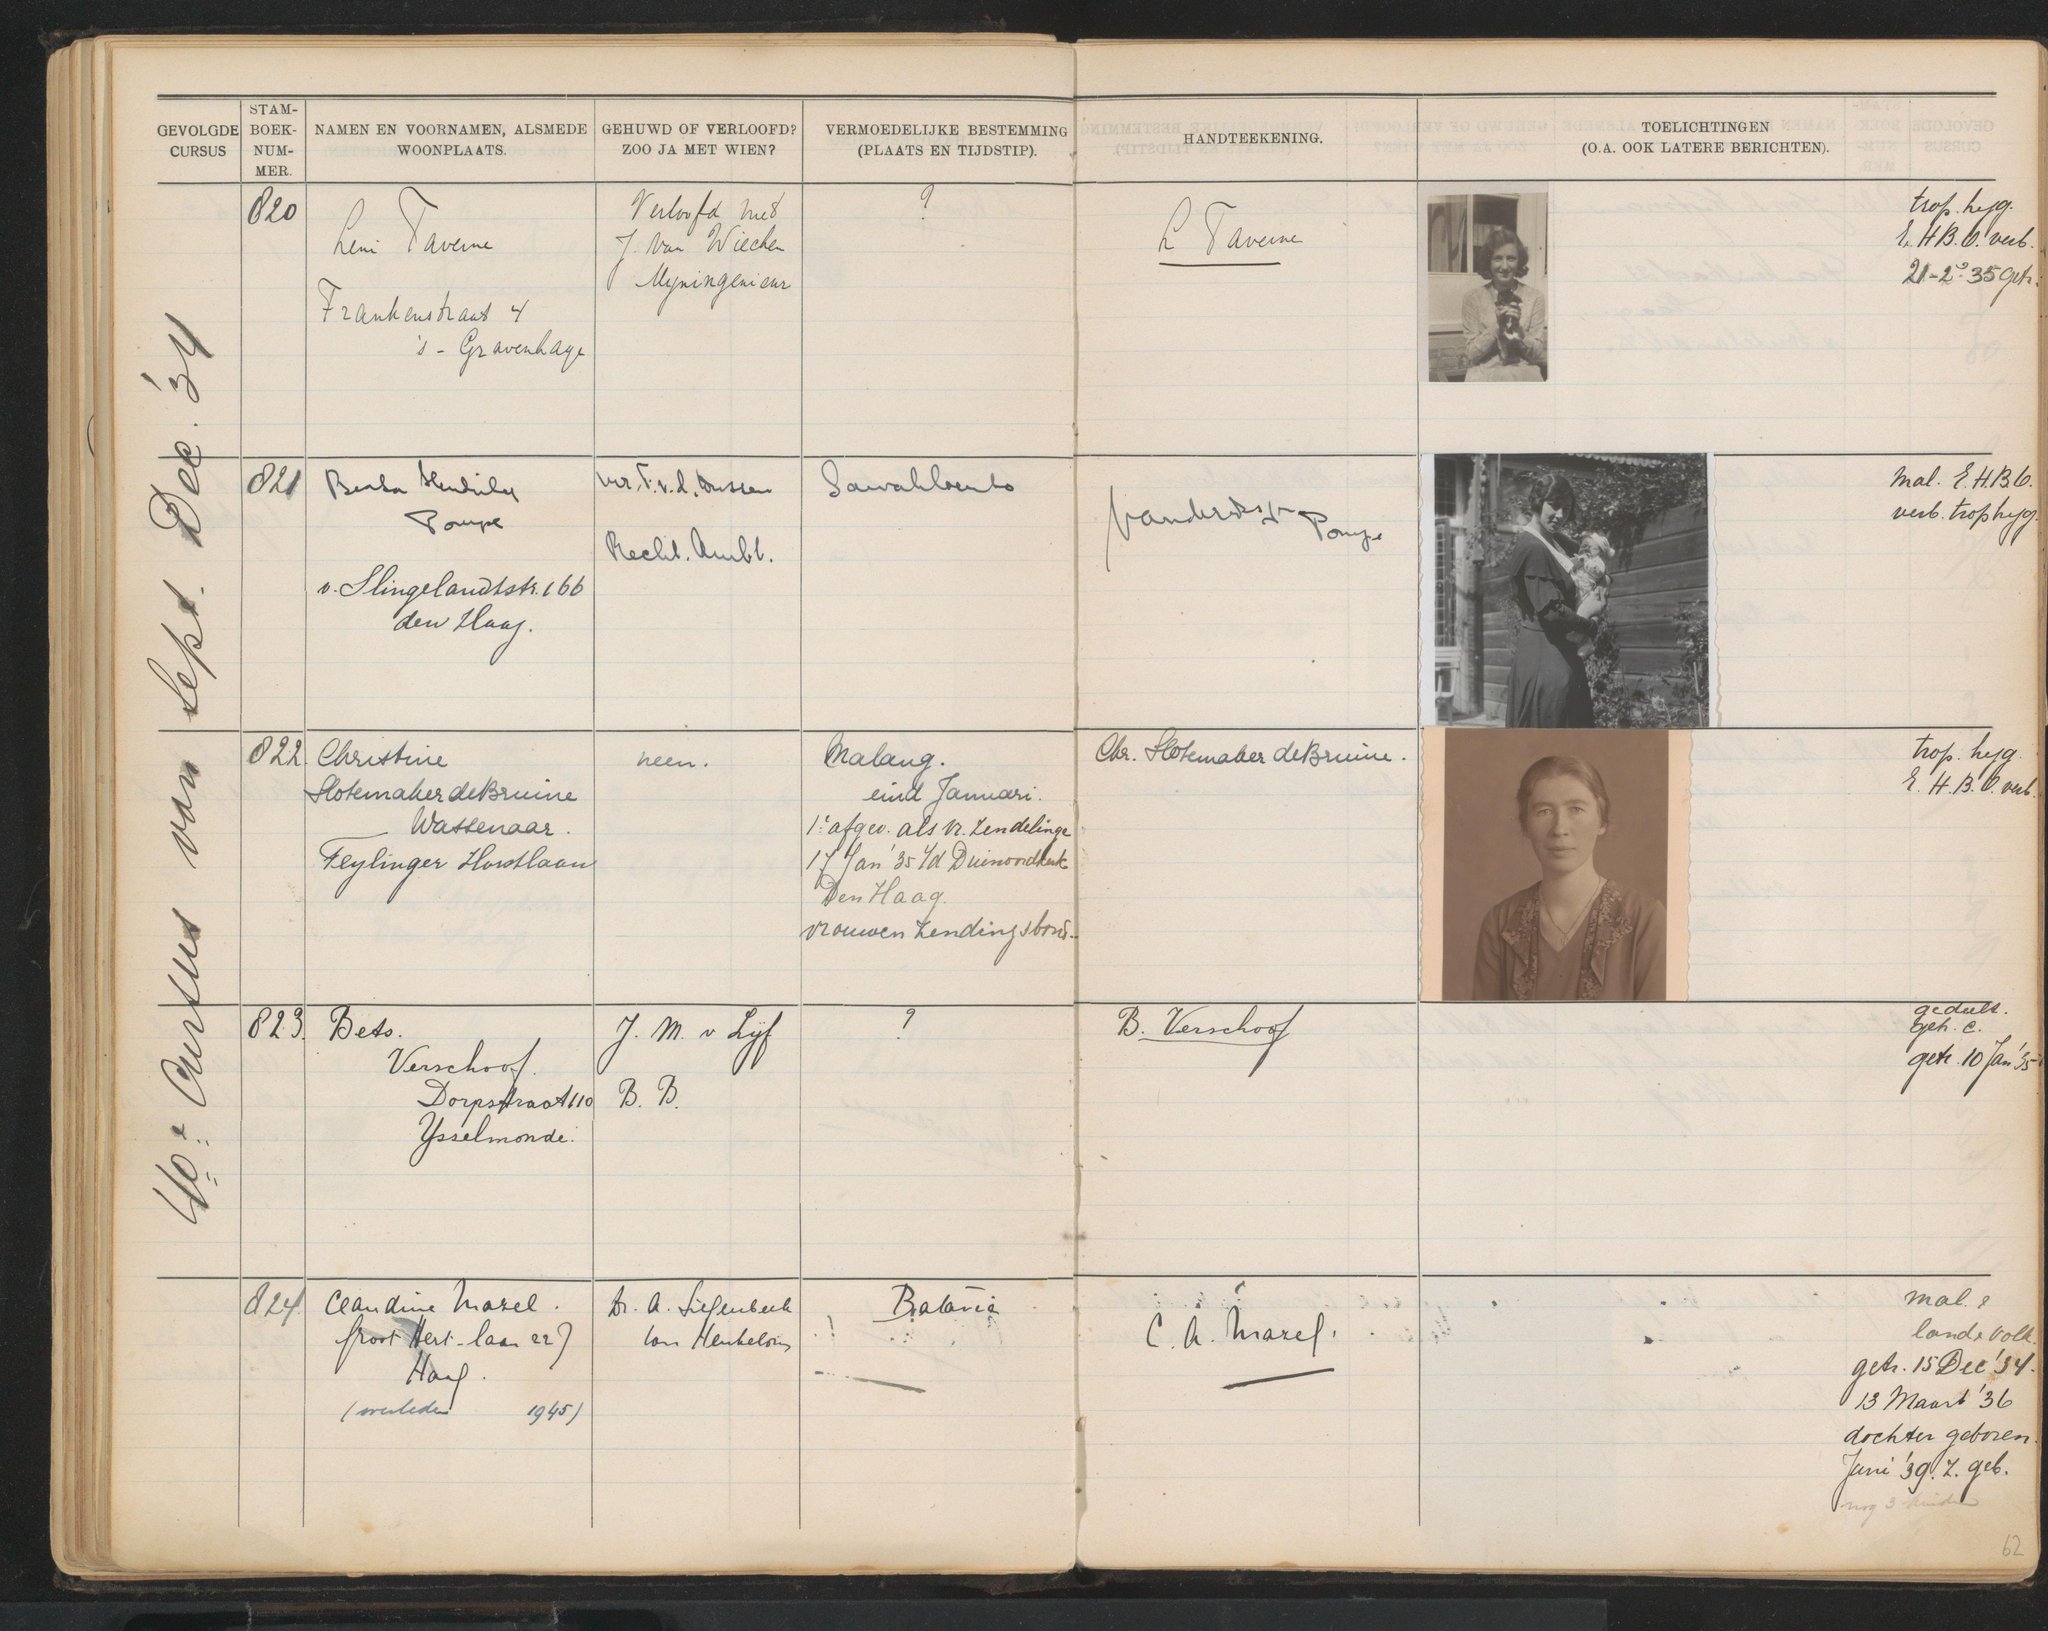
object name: photograph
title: Blad 62 uit Stamboek van de leerlingen der Koloniale School voor Meisjes en Vrouwen te 's-Gravenhage deel II (1930-1949)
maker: Anonymous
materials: paper, photographic support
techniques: photography, printing, writing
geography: the hague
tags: further education (+ pupil), further education, the hague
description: Twee pagina's met gegevens van de deelnemers aan de 40e driemaandelijkse cursus van september tot december 1934, stamboeknummers 820 tot en met 824. Onderdeel van Stamboek van de leerlingen der Koloniale School voor Meisjes en Vrouwen te 's-Gravenhage deel II (1930-1949).